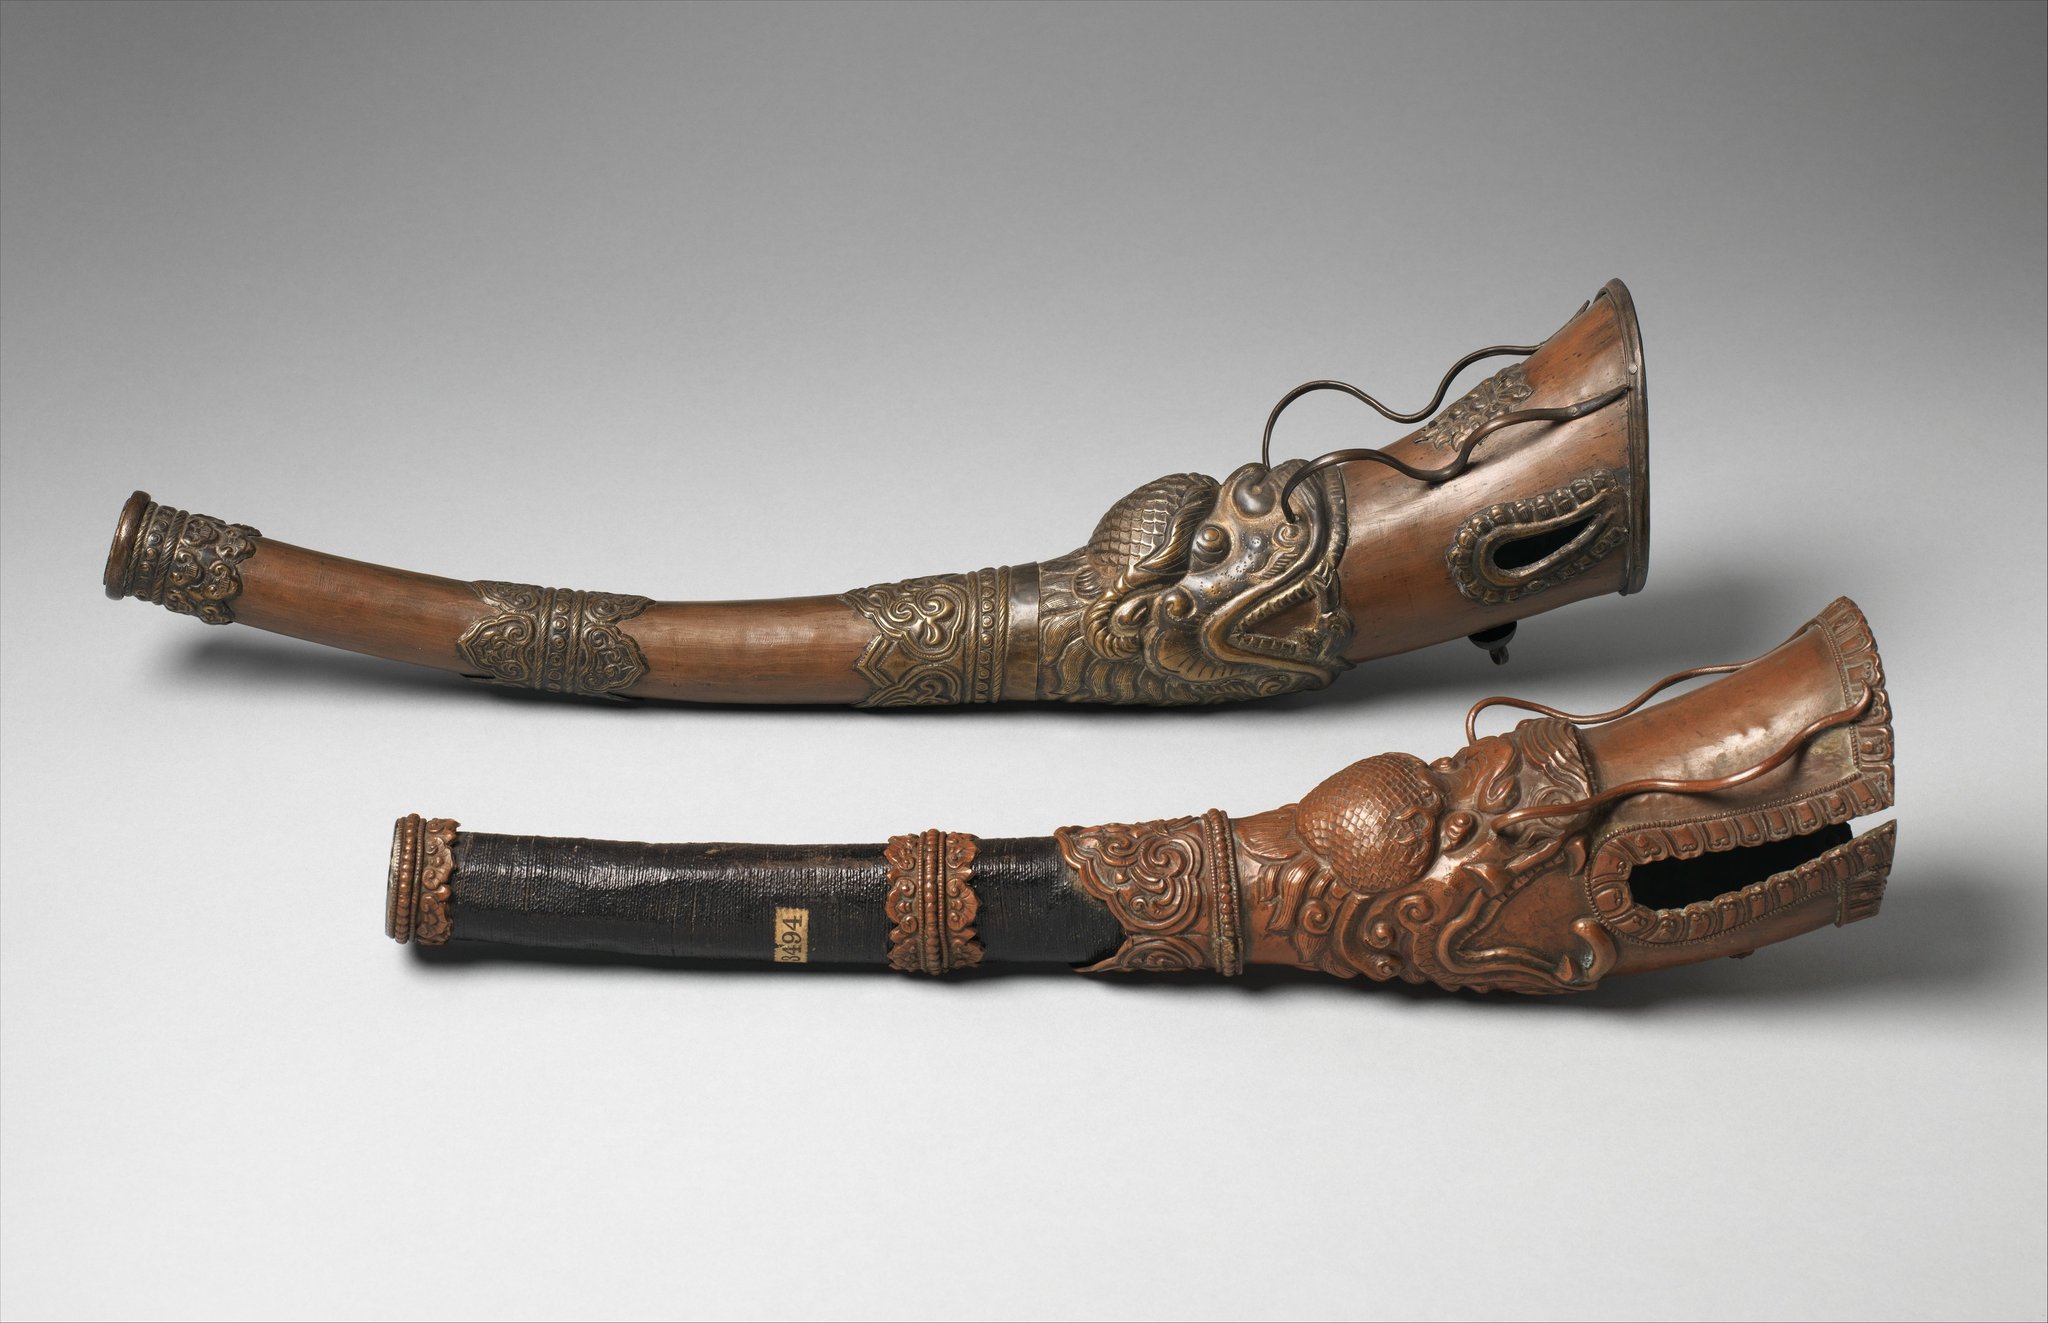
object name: rkangling leg bone flute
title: Rkangling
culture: tibetan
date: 1801-1900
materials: bone, copper, thread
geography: tibet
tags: mythical creatures